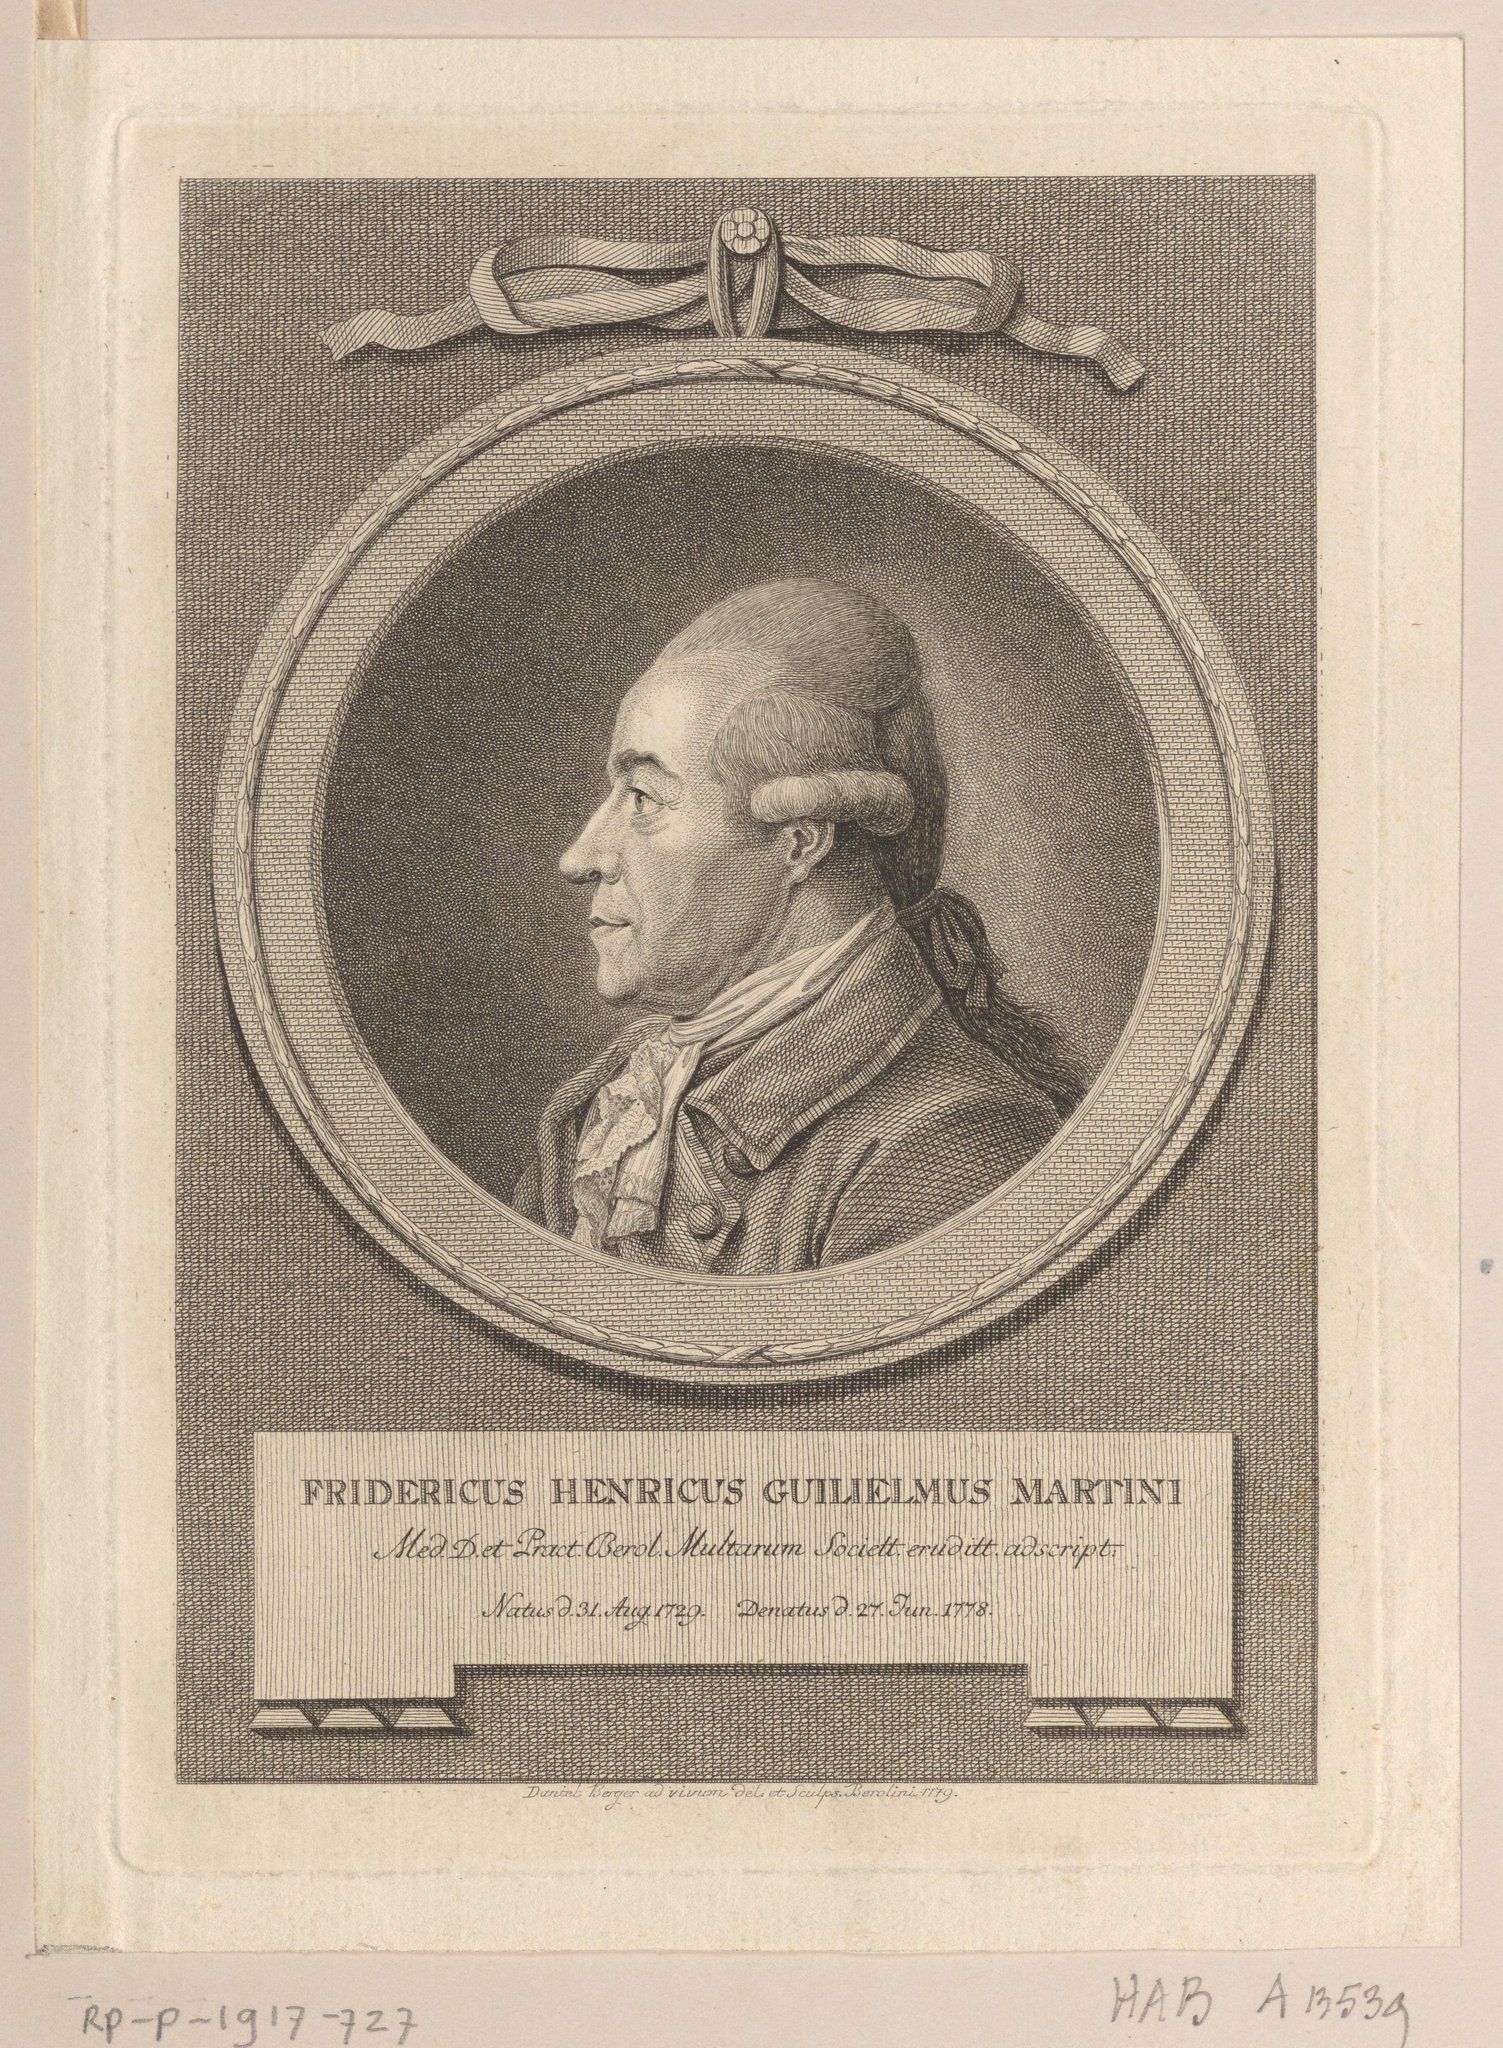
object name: print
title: Portret van Friedrich Heinrich Wilhelm Martini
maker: daniel berger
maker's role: print maker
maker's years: 1744-1824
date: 1779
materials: paper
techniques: engraving, etching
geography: berlin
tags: ornament ~ medallion, historical persons, physician, doctor (+ portrait of scholar, scientist)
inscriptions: collector's mark: Lugt 2228